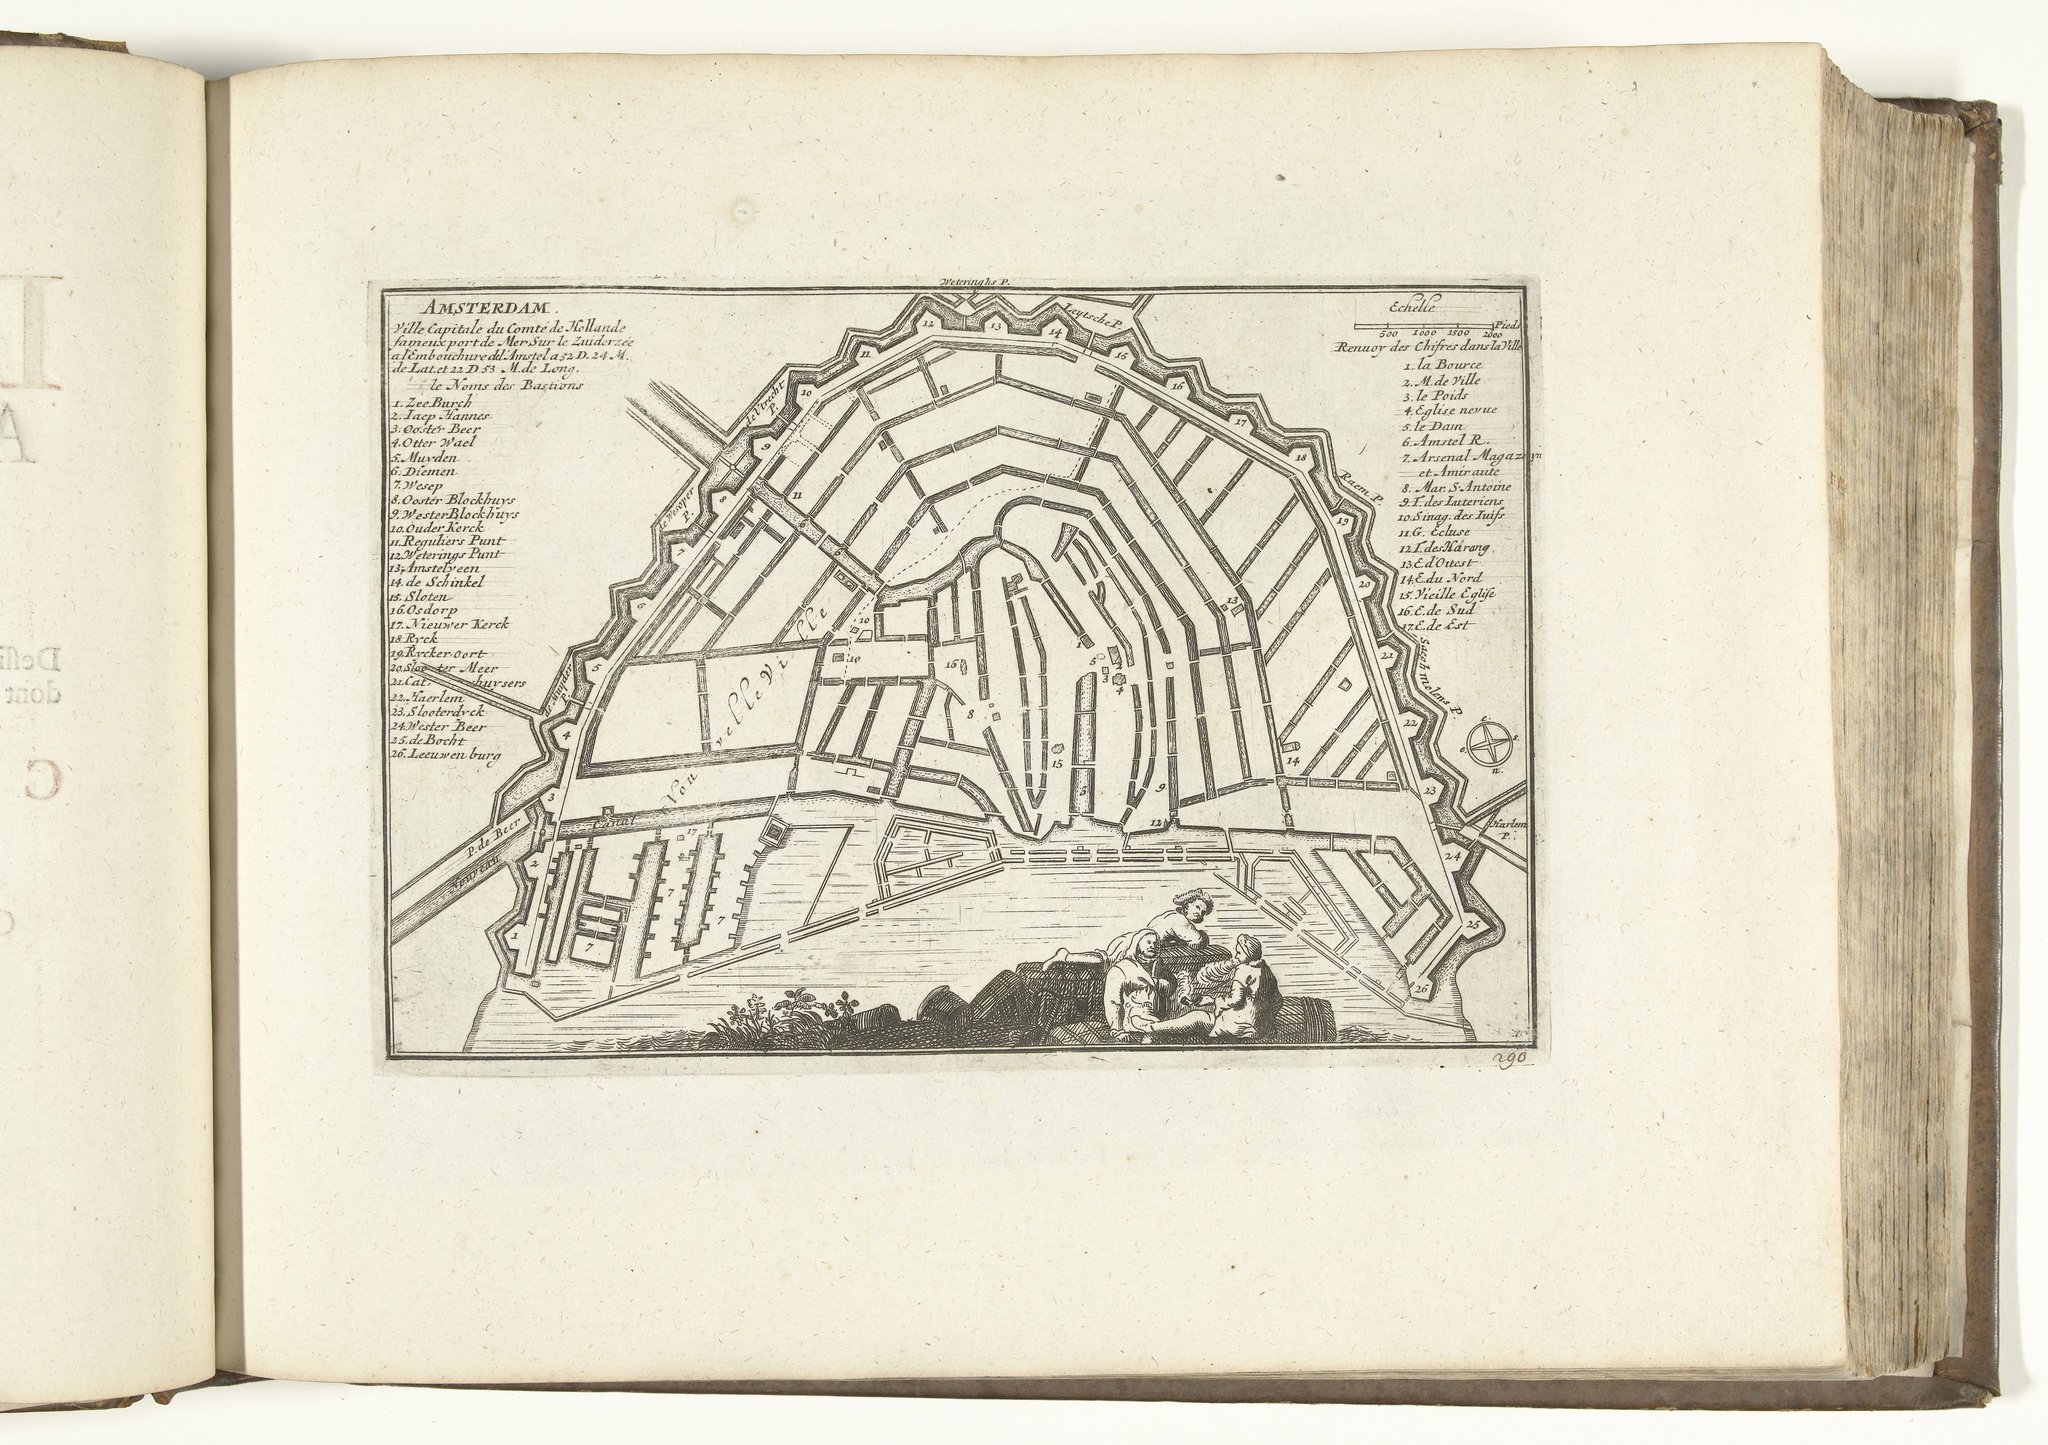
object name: print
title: Map of Amsterdam, 1726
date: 1726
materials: paper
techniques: etching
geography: leiden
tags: fortress, maps of cities, amsterdam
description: Plattegrond van de verdedigingswerken om Amsterdam. Plaat nr. 290 in deel XIII van het prentwerk: Les Forces de l'Europe, Asie, Afrique et Amerique ... Comme aussi les Cartes des Côtes de France et d'Espagne uit 1726, dit tweede deel met 271 met de hand genummerde platen van vermaarde sterke steden en vestingen in het kader van de Spaanse Successieoorlog 1701-1713. Voor het merendeel zijn deze platen gekopieerd naar de anonieme Franse platen van vermaarde sterke steden en vestingen: in Les forces de l'Europe en in: Le theatre de la guerre, dans les Pays-Bas, beide oorspronkelijk uitgegeven door Nicolas de Fer te Parijs (1693-1697) in het kader van de Negenjarige Oorlog. Titels en opschriften in het Frans.